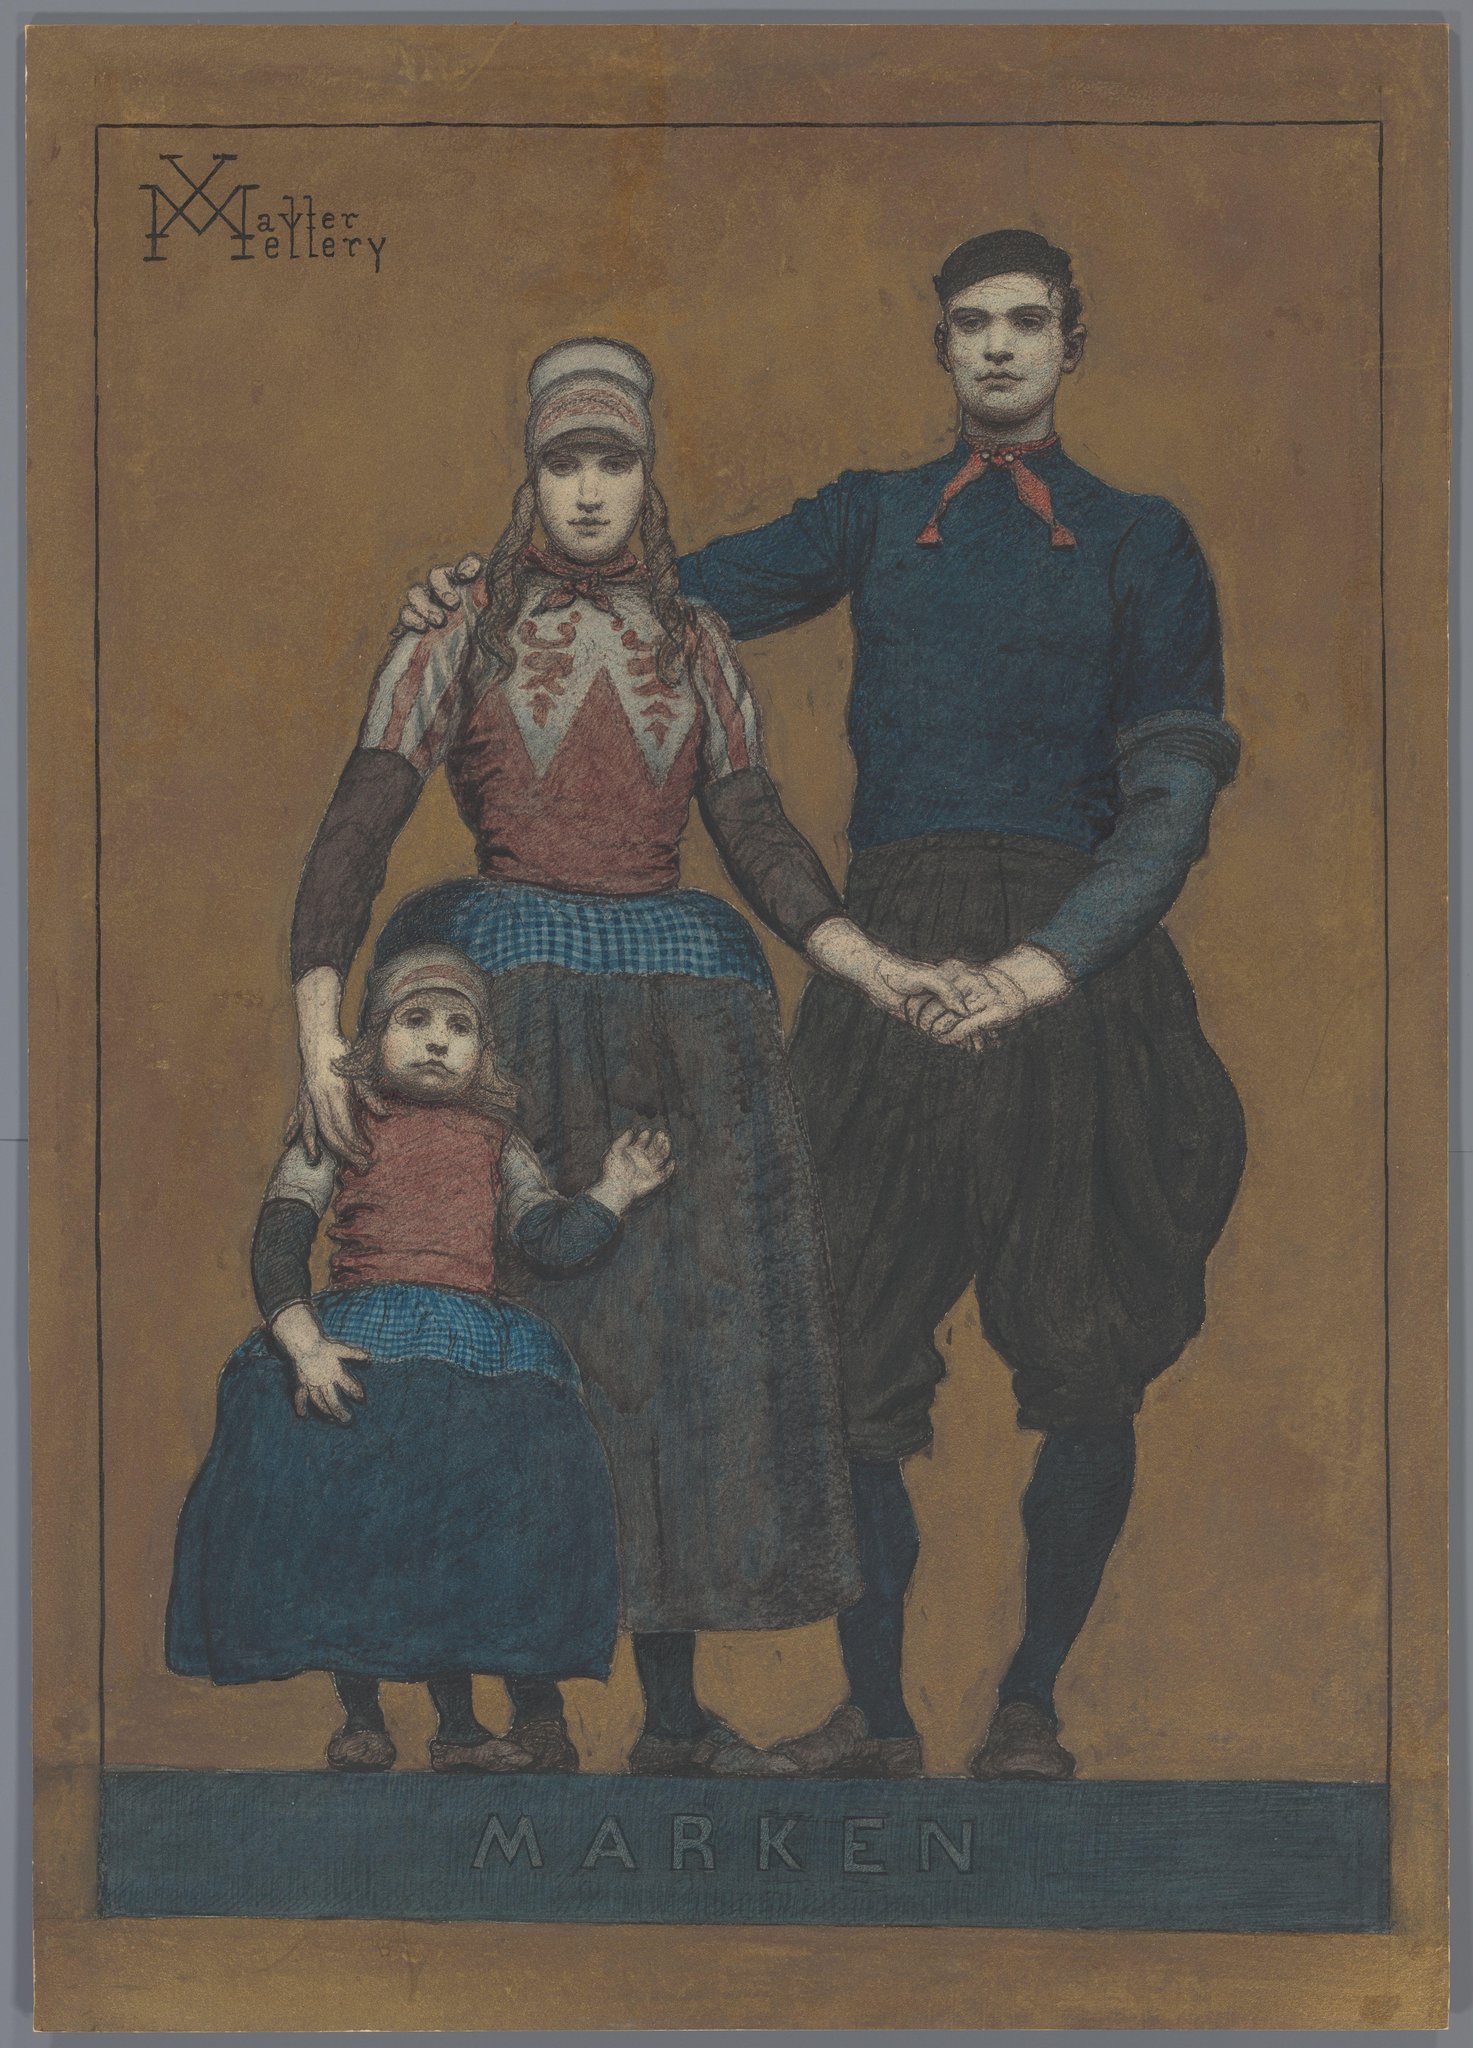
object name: drawing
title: La Sainte Famille, Marken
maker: xavier mellery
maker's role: print maker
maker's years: 1845-1921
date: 1889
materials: cardboard, chalk, paint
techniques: brush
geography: marken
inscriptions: signature: ‘Xavier Mellery’, annotation: ‘MARKEN’, signature: ‘XM’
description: Mellery, a painter from Brussels, visited the island of Marken around 1878. At that time there was a lively exchange between Dutch and Belgian artists. On Marken, Mellery made studies of the local population in traditional costume. In the final work, the family in Marken garb are depicted as silhouettes standing out against the golden background. The typically Dutch figures thus resemble a Byzantine icon.